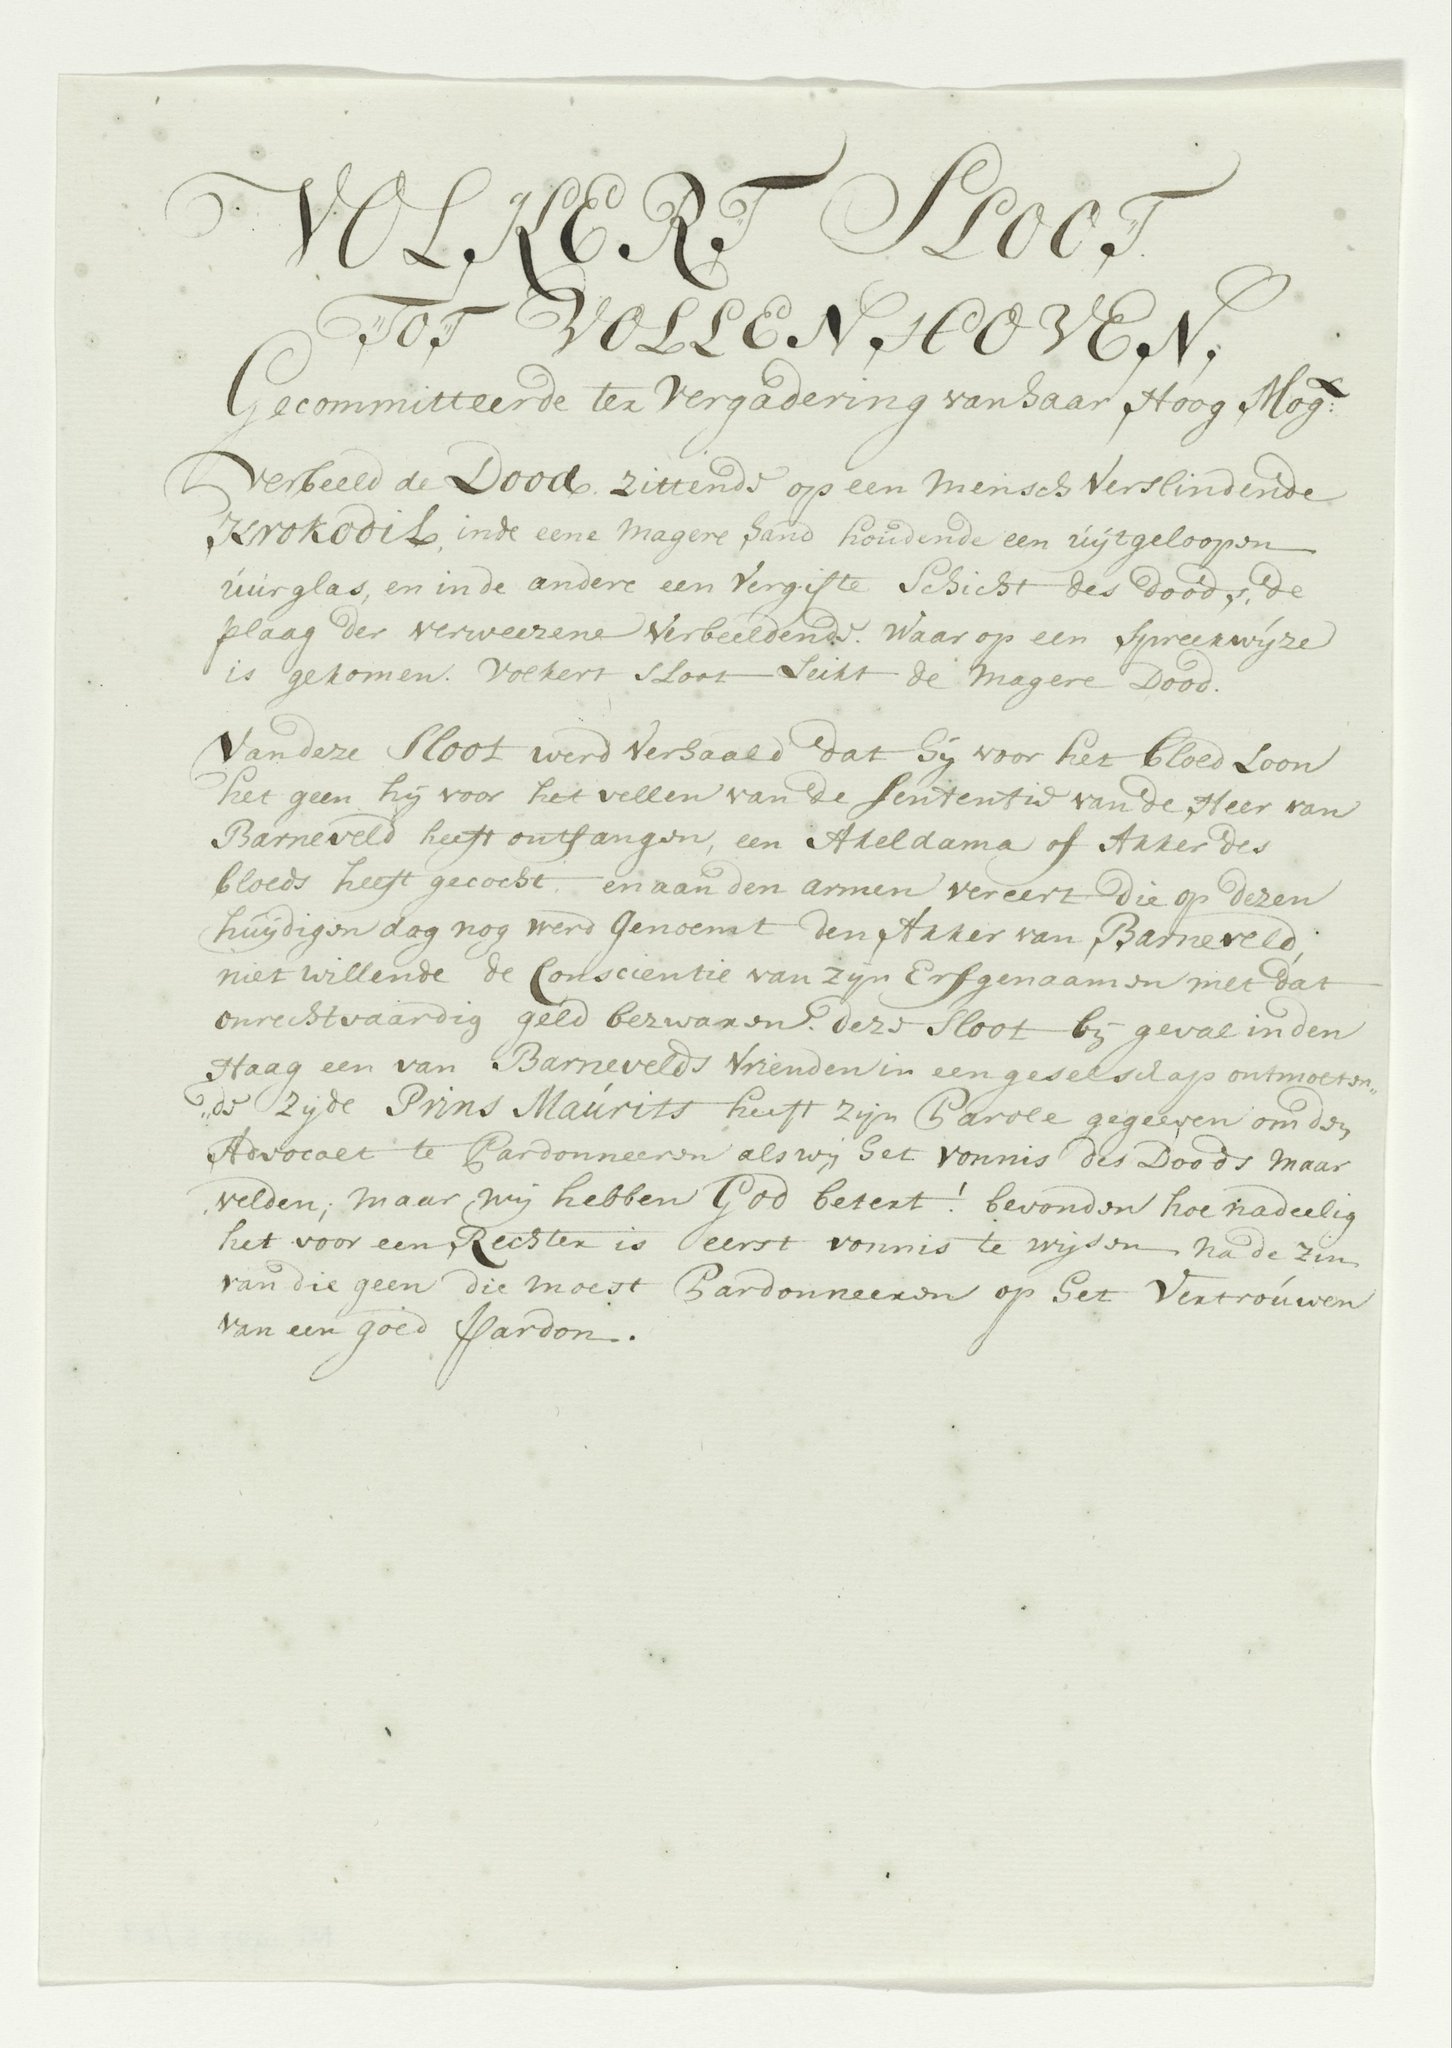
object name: manuscript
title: Spotvers bij het portret van Volkert Sloot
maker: Anonymous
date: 1710-1720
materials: ink, paper, watercolor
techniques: pen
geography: netherlands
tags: the hague, johan van oldenbarnevelt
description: Spotprent van Volkert Sloot, rechter van Van Oldenbarnevelt; de Dood met in linkerhand een zandloper en rechterhand stok en wapen, zittend op een krokodil. In krans van bladeren. Daaronder cartouche waarin naam en daarboven nr. 21. Behorende bij serie aquarellen in boek.